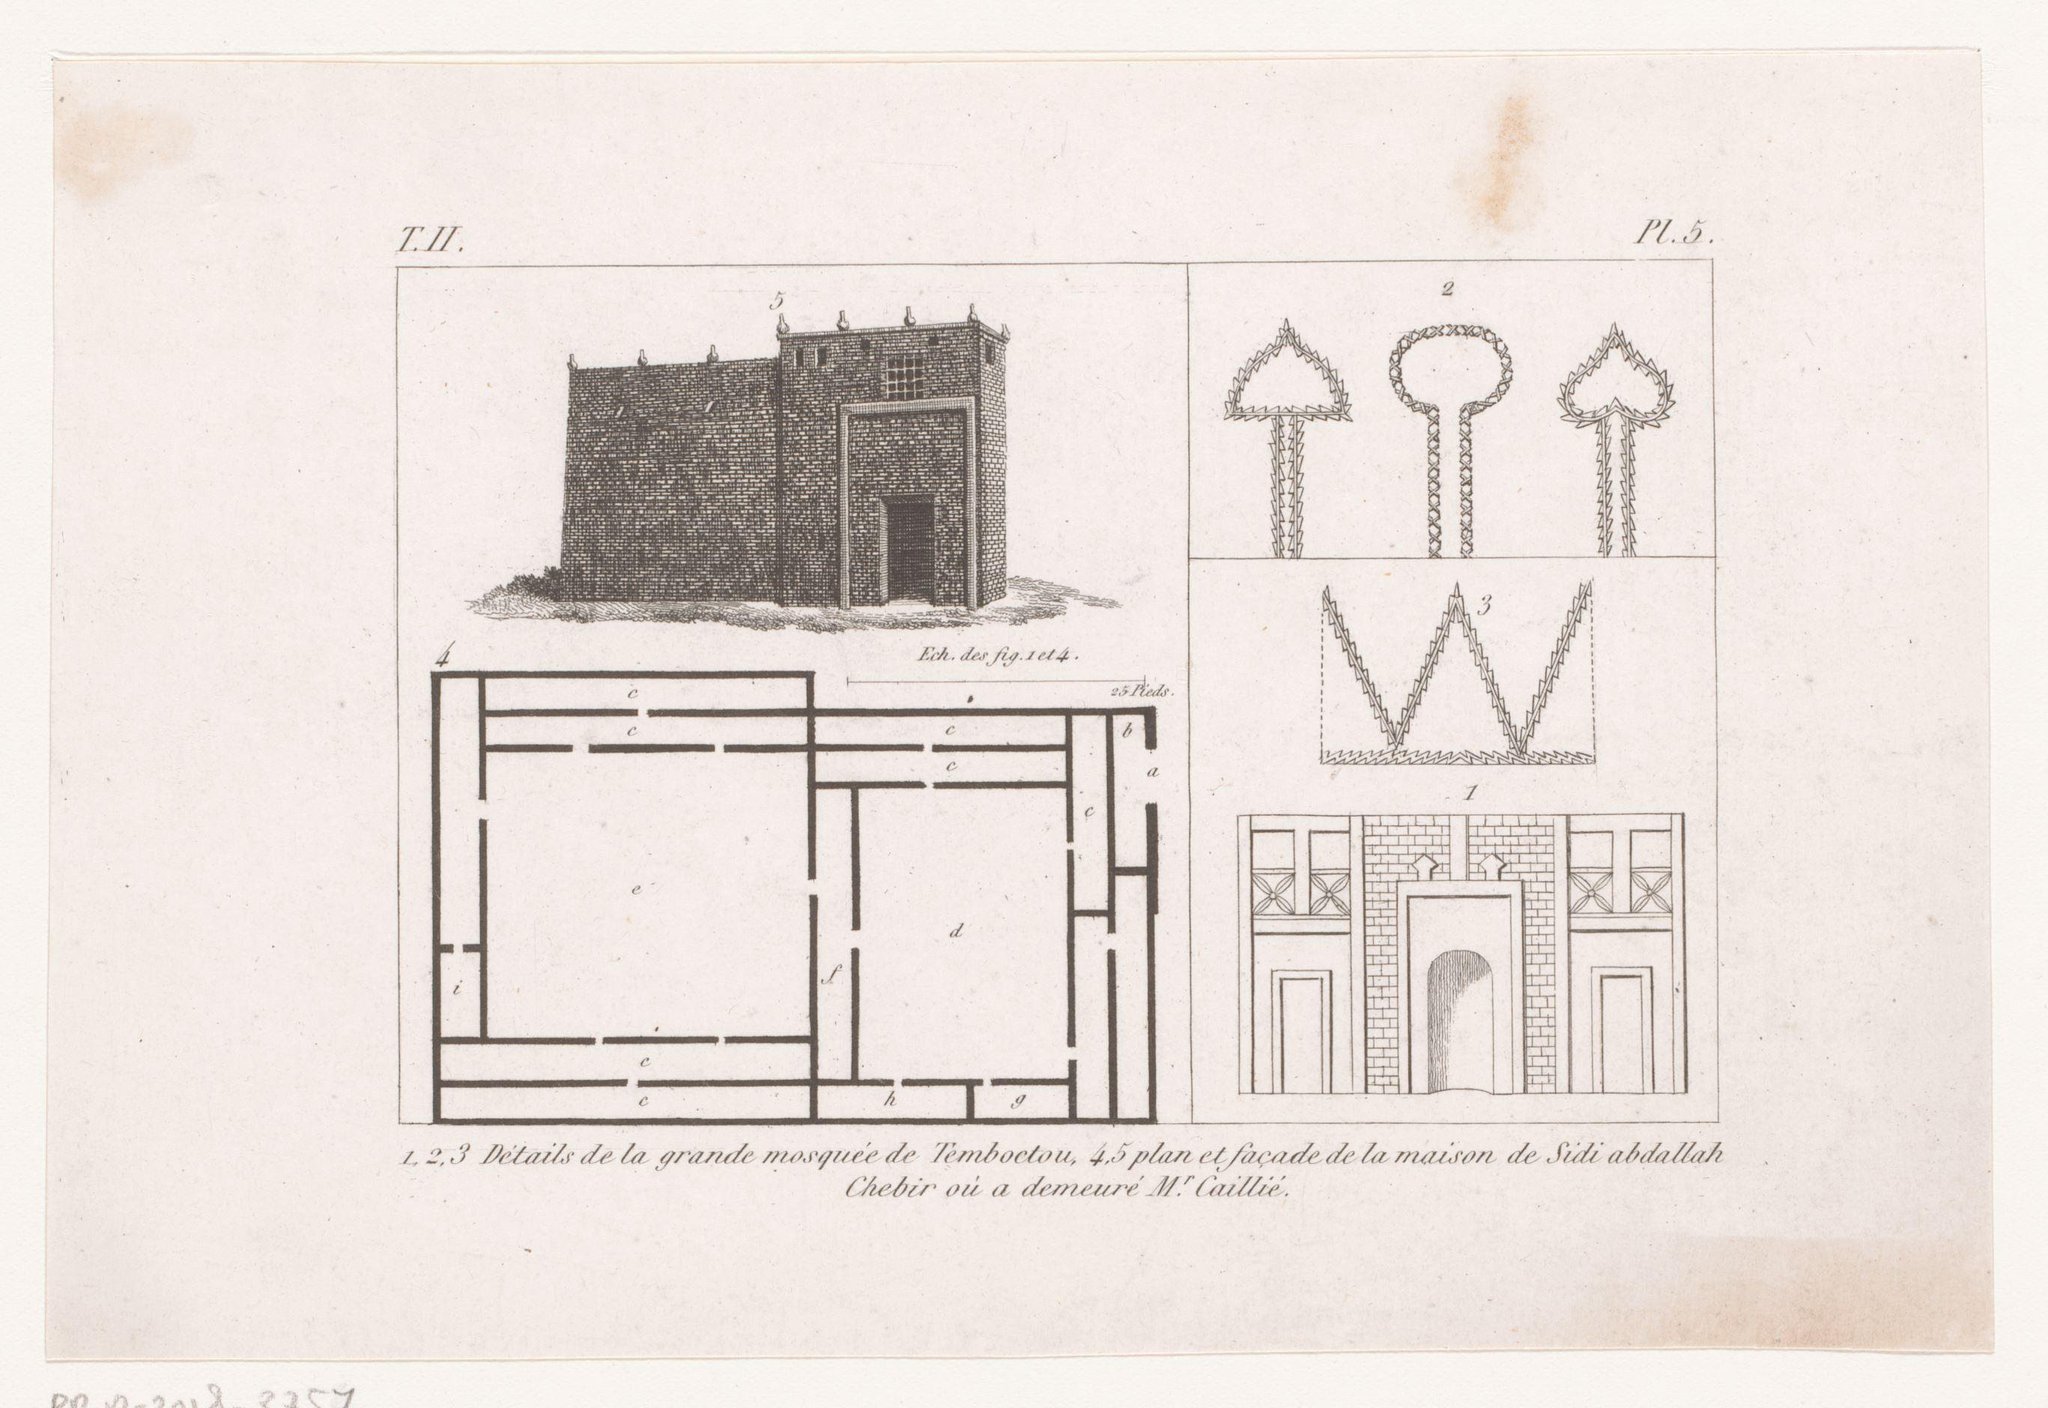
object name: print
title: Details de la grande mosquee de Temboctou, plan et facade de la maison de Sidi abdallah Chebier ou a demeuré Mr. Caillié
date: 1830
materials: paper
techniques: etching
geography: paris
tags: architectural detail, temple, shrine ~ islam, mohammedanism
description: Prent uit: Caillié, René. Journal d'un voyage a Temboctou et a Jenné, dans l'Afrique centrale. Parijs: Pierre Mongie et al., 1830, dl. 2.